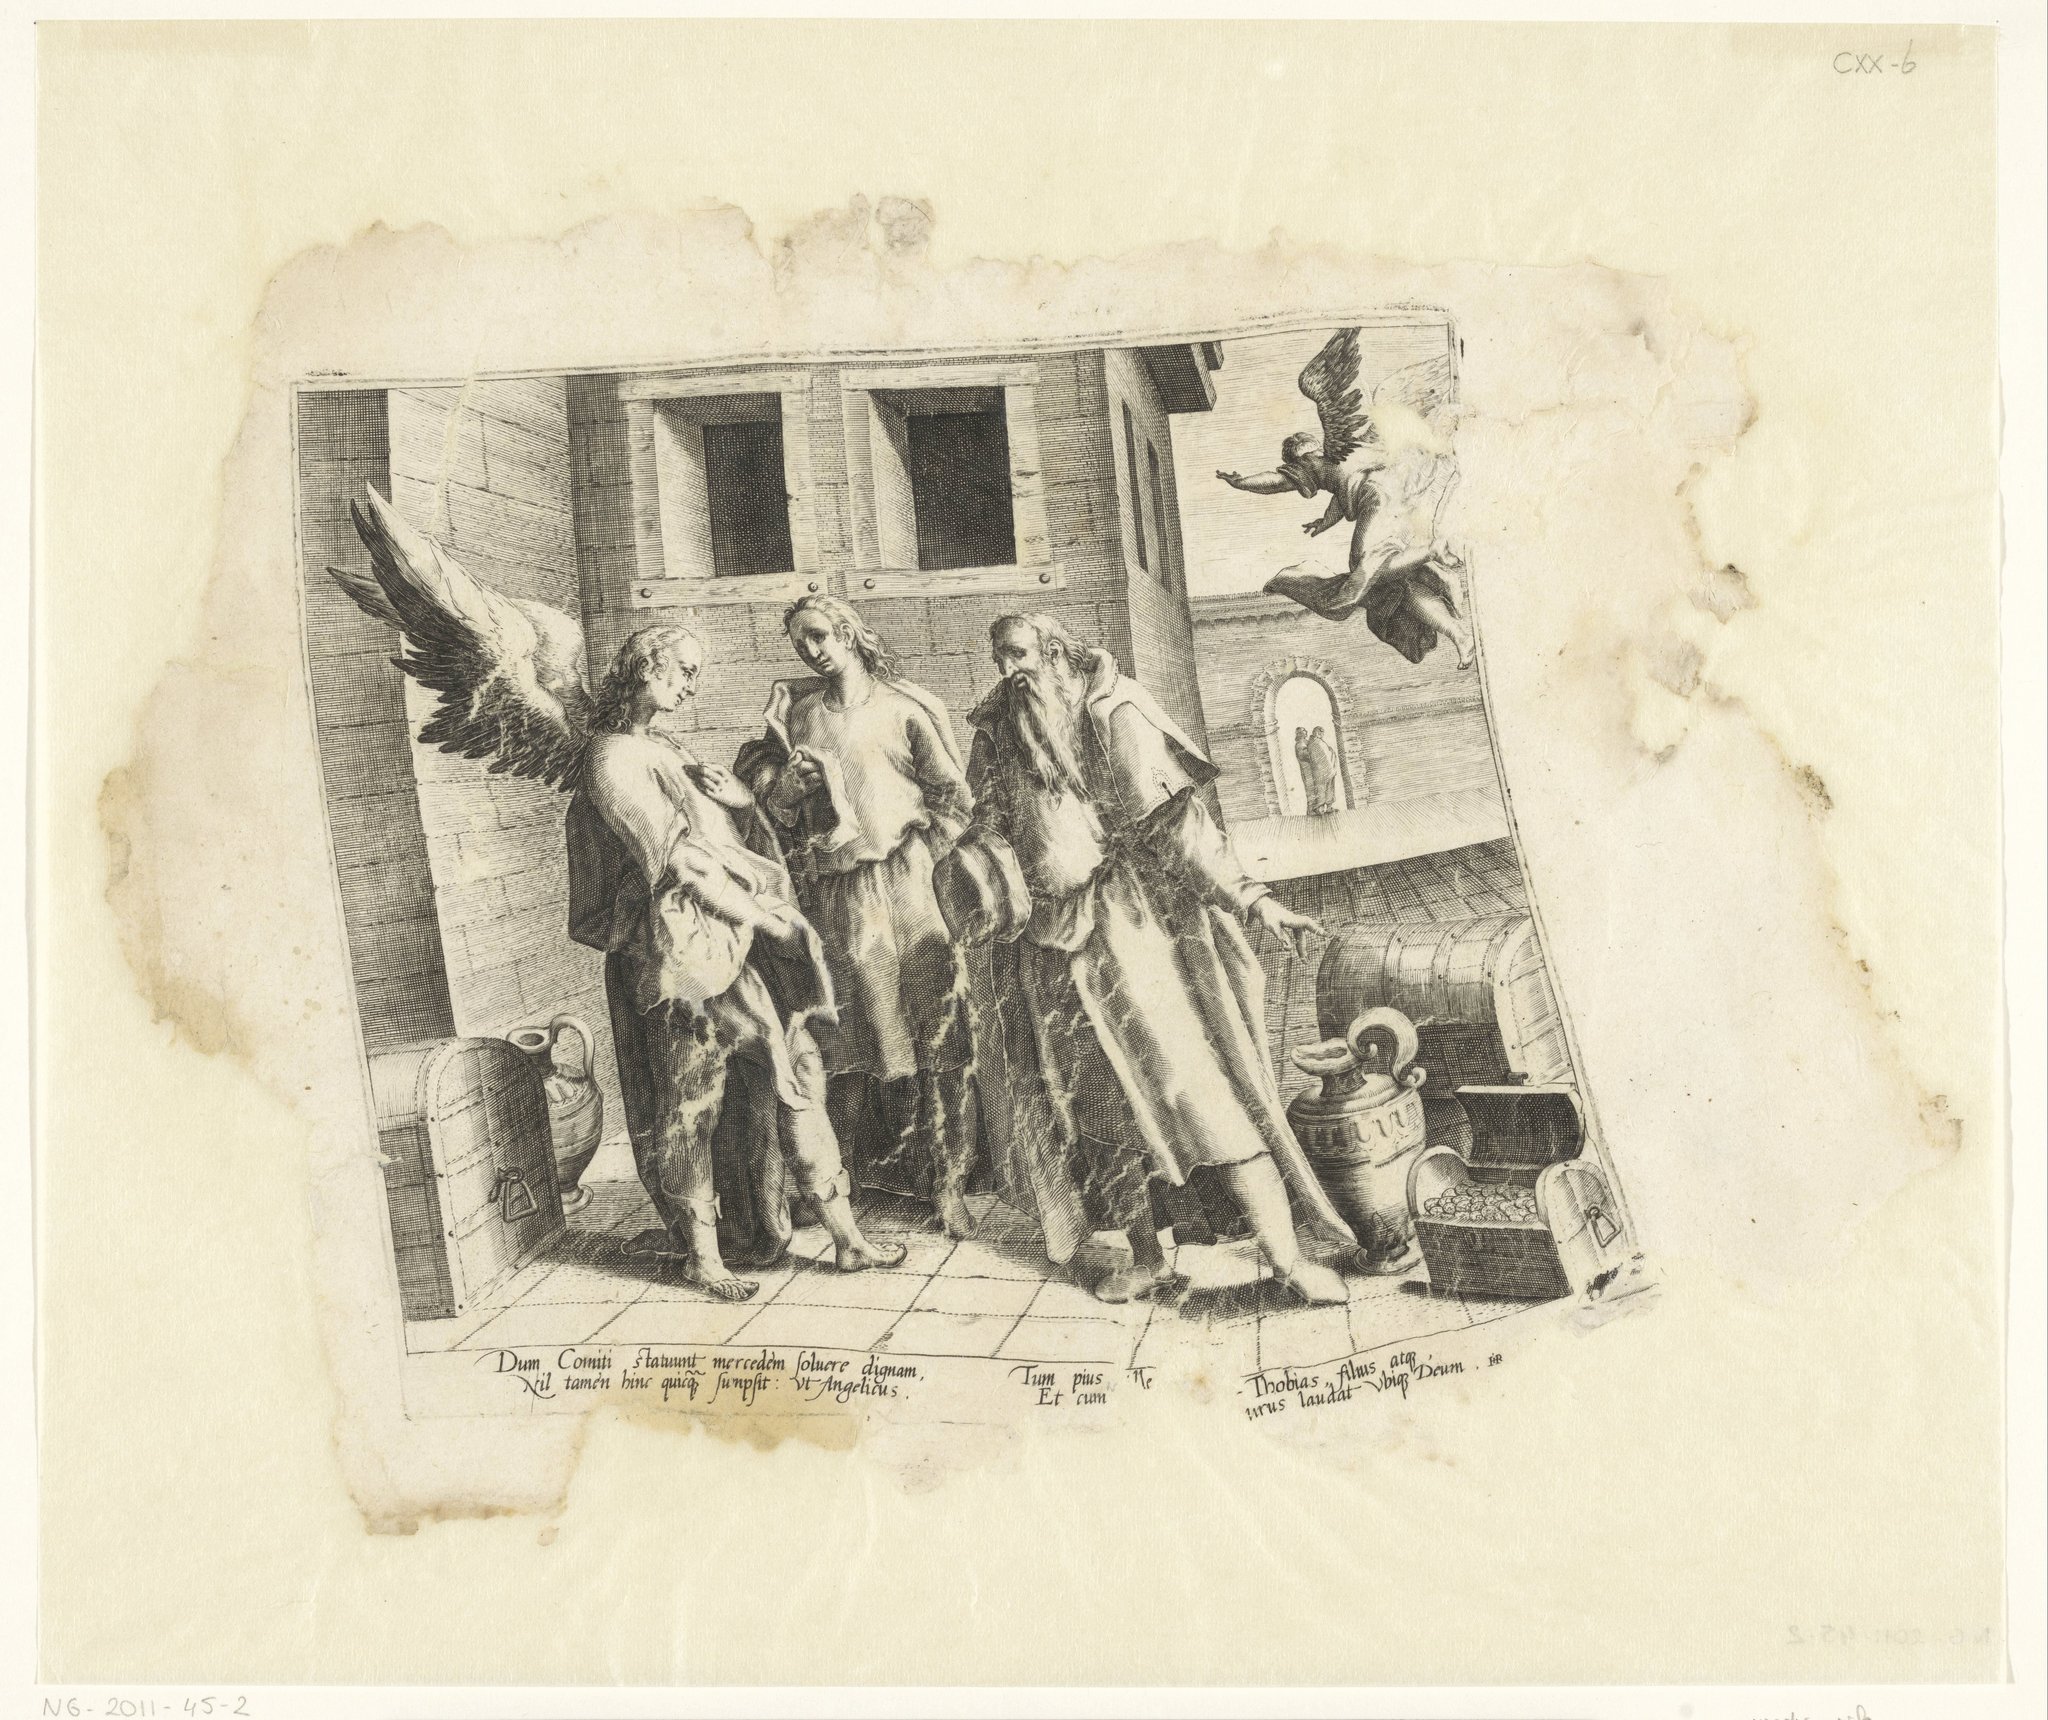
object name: print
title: Afscheid van de engel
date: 1580-1596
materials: paper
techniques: engraving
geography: amsterdam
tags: tobias and his father offer gifts to the angel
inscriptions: watermark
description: De prenten in de Nova Zembla collectie zijn tijdens een expeditie van Willem Barendsz en Jacob van Heemskerk in 1596-1597 noodgedwongen in het winterkamp, het ‘Behouden Huis’, op het eiland achtergelaten. De prenten waren in één of meerdere stapels als handelswaar meegenomen vanuit Amsterdam. Bijna drie eeuwen later, in 1871, keerde de Noor Elling Carlsen terug naar Nova Zembla en vond daar de restanten van het ‘Behouden Huis, inclusief een groot deel van de inventaris. Een deel van de prenten, in de vorm van aaneengekoekte kluiten, werd toen ook teruggevonden. De papierkluiten waren soms op meerdere plekken gebroken. Tussen 1975-1979 zijn de prenten van elkaar gescheiden. Dit leverde in totaal ca. 1000 fragmenten van ca. 400 afdrukken van ca. 150 verschillende prenten op. Voor zover mogelijk zijn de fragmenten samengevoegd en zijn de prenten gereconstrueerd.